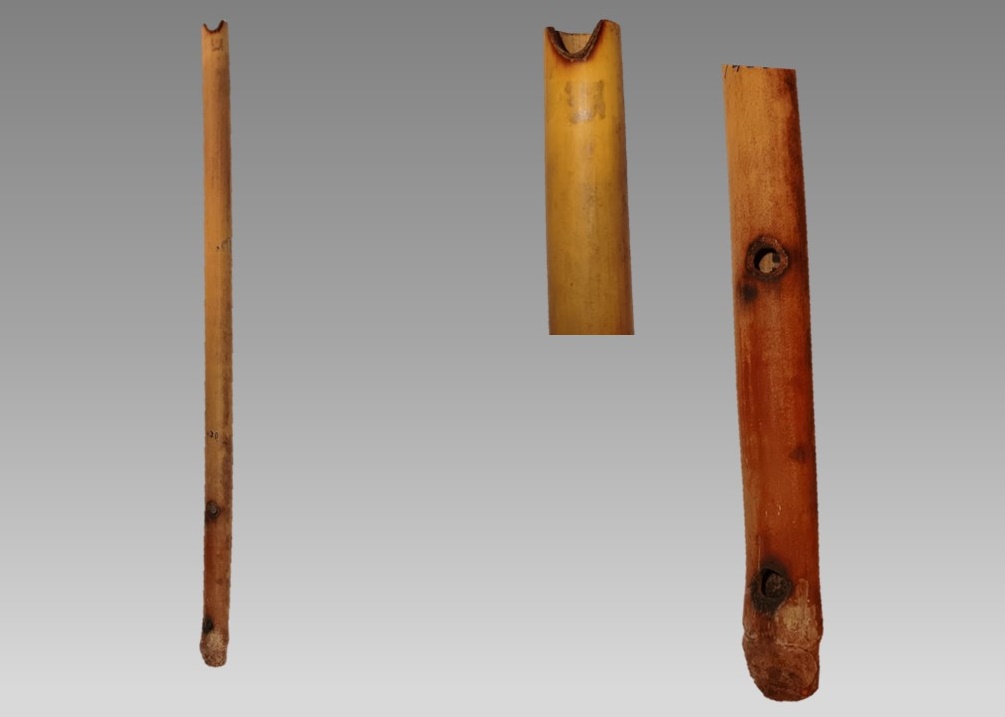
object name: gore notched flute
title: Gore (Notched Flute)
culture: polynesian or norfolk island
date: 1867-1900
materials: bamboo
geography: australia